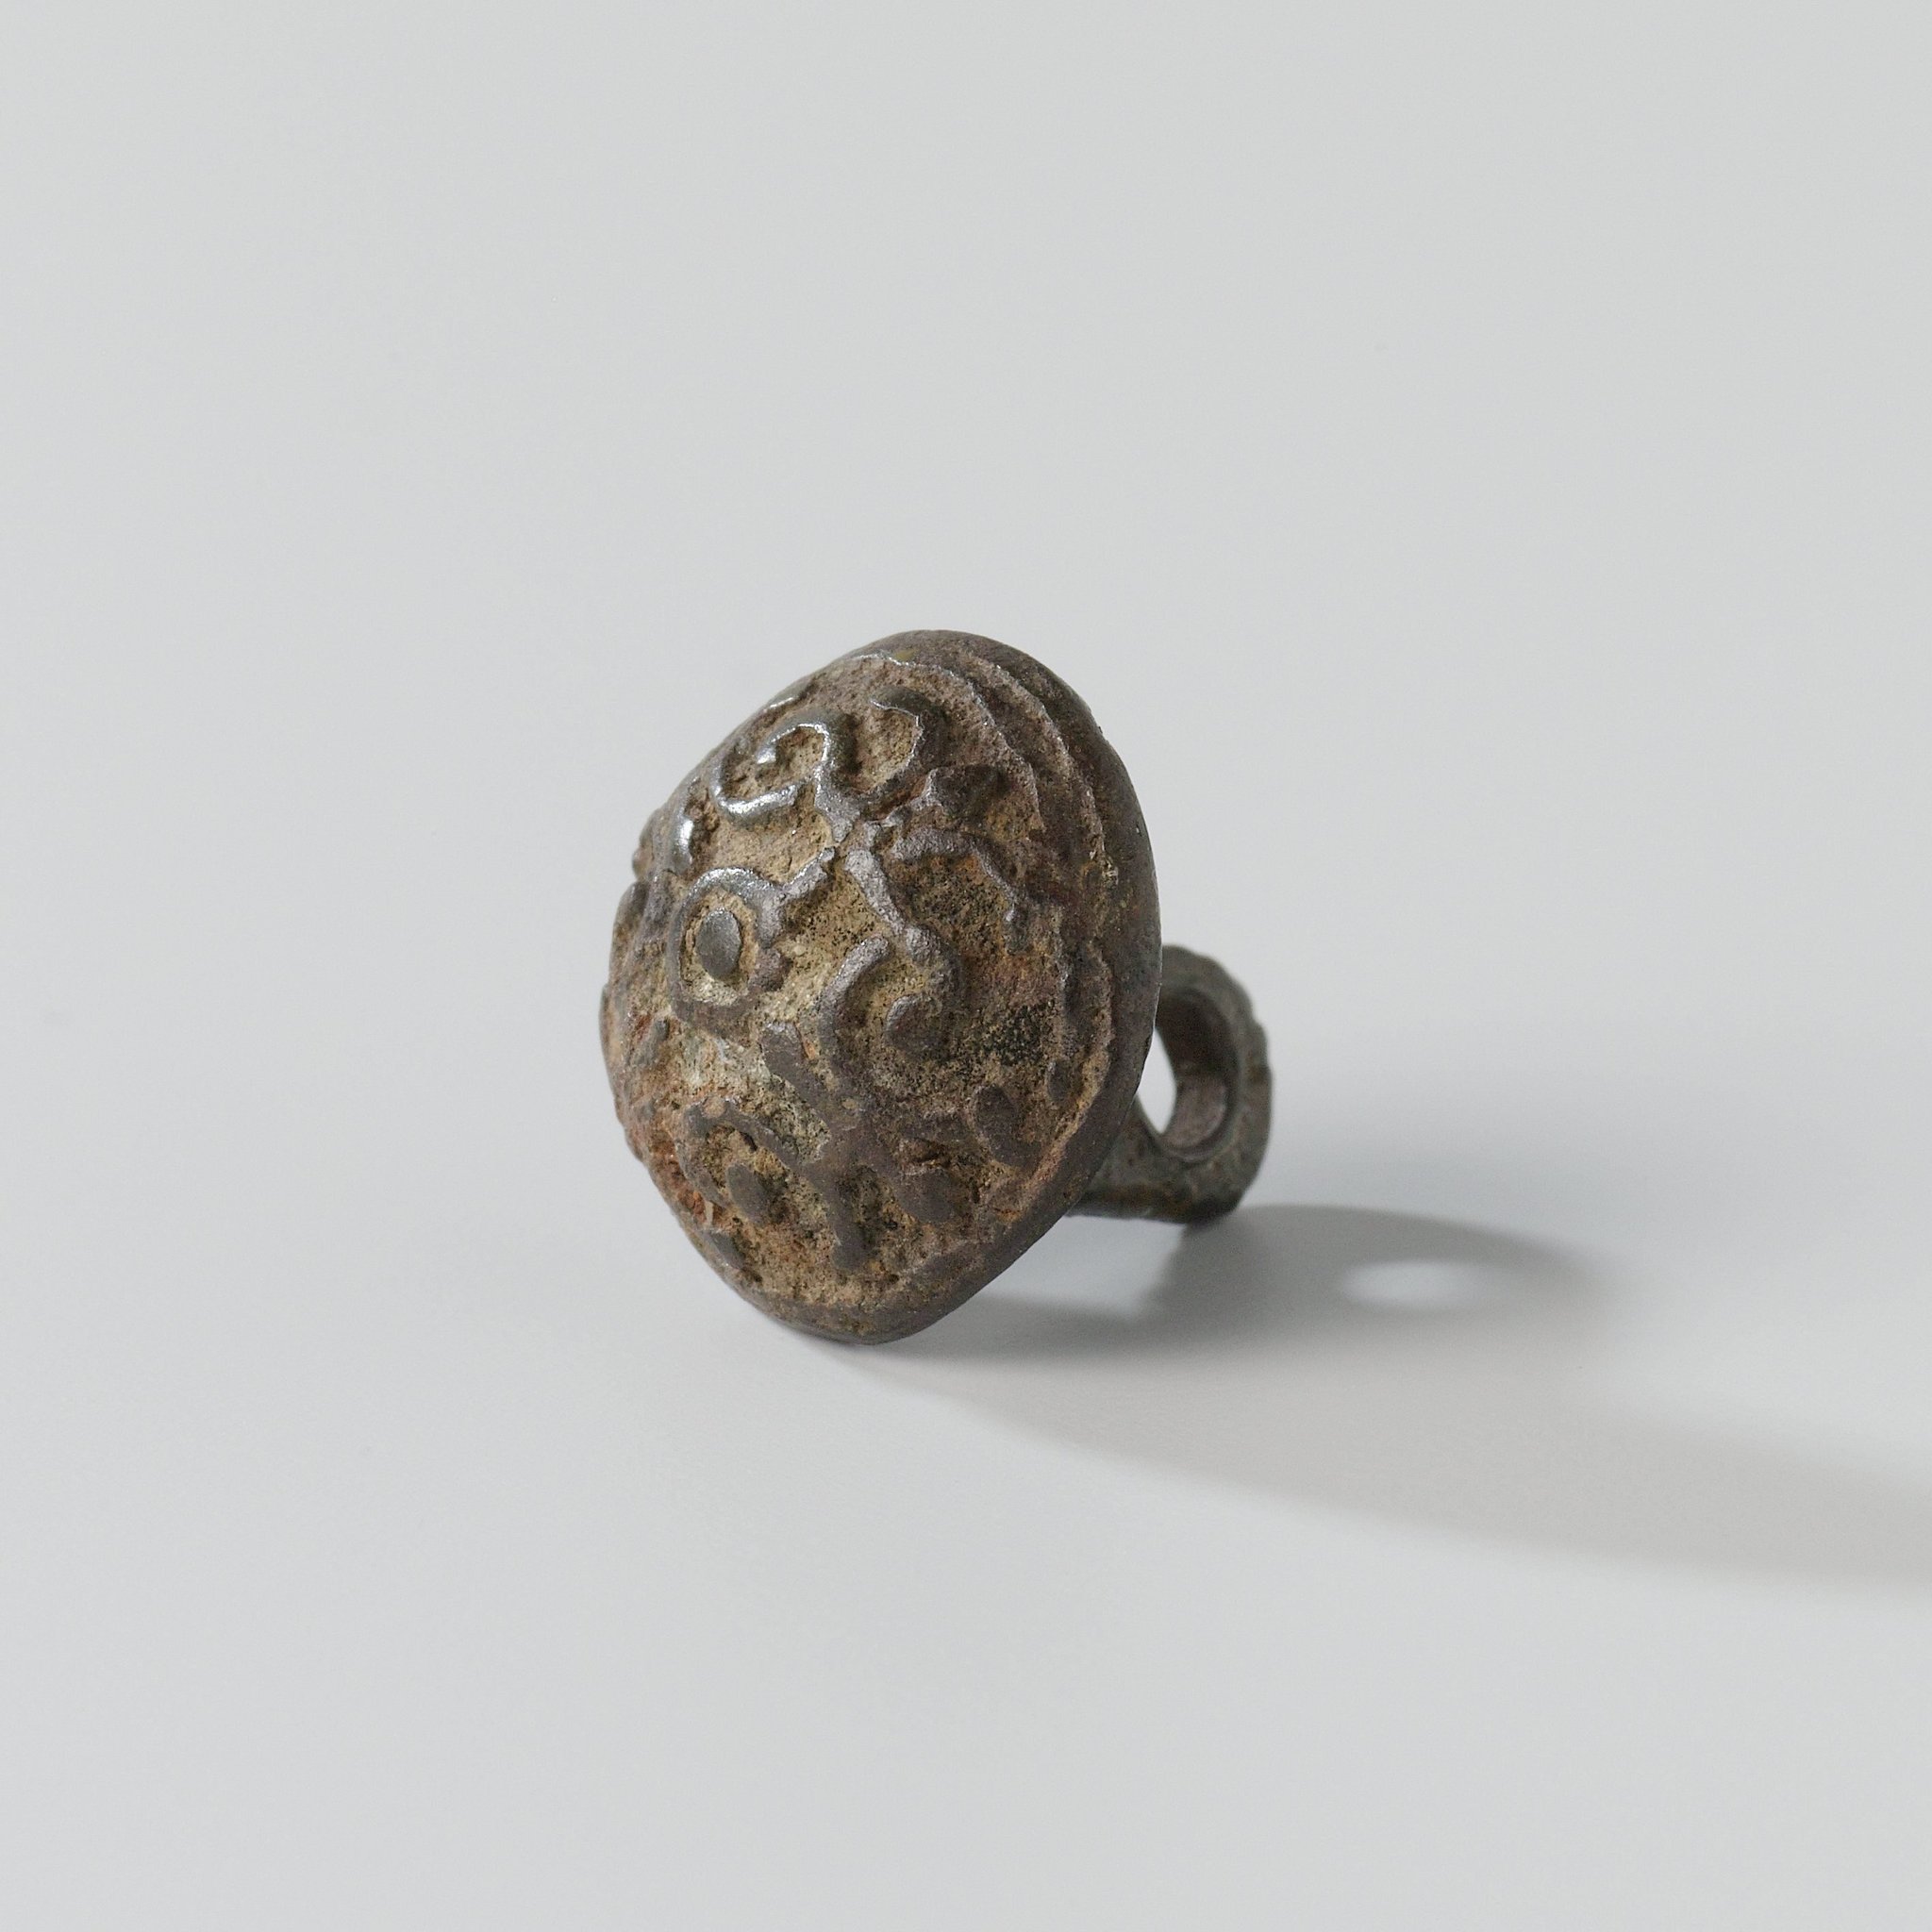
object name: button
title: Knoop versierd met lelies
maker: Anonymous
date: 1590-1596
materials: brass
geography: netherlands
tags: willem barendsz., amsterdam, jacob van heemskerck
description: Knoop, versierd met lelies. De knopen NG-NM-7723-7, NG-NM-7723-8 en NG-NM-7723-10 zijn niet identiek.